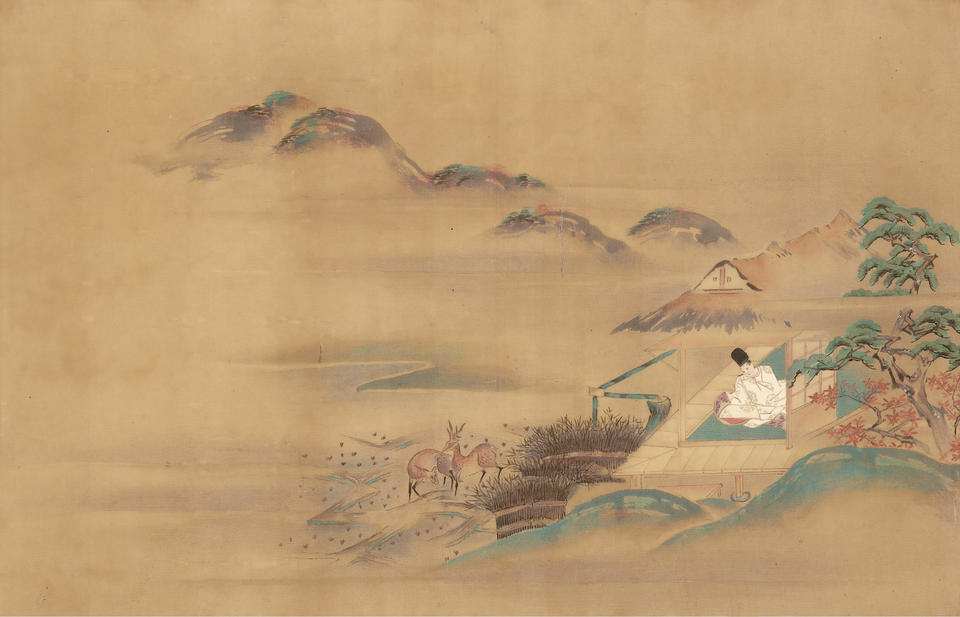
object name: handscroll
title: Eight Views from The Tale of Genji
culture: japanese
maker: ishiyama moroka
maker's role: artist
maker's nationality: japanese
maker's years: 1669-1734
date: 1600-1800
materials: gold, ink, silk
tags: men,deer,landscapes